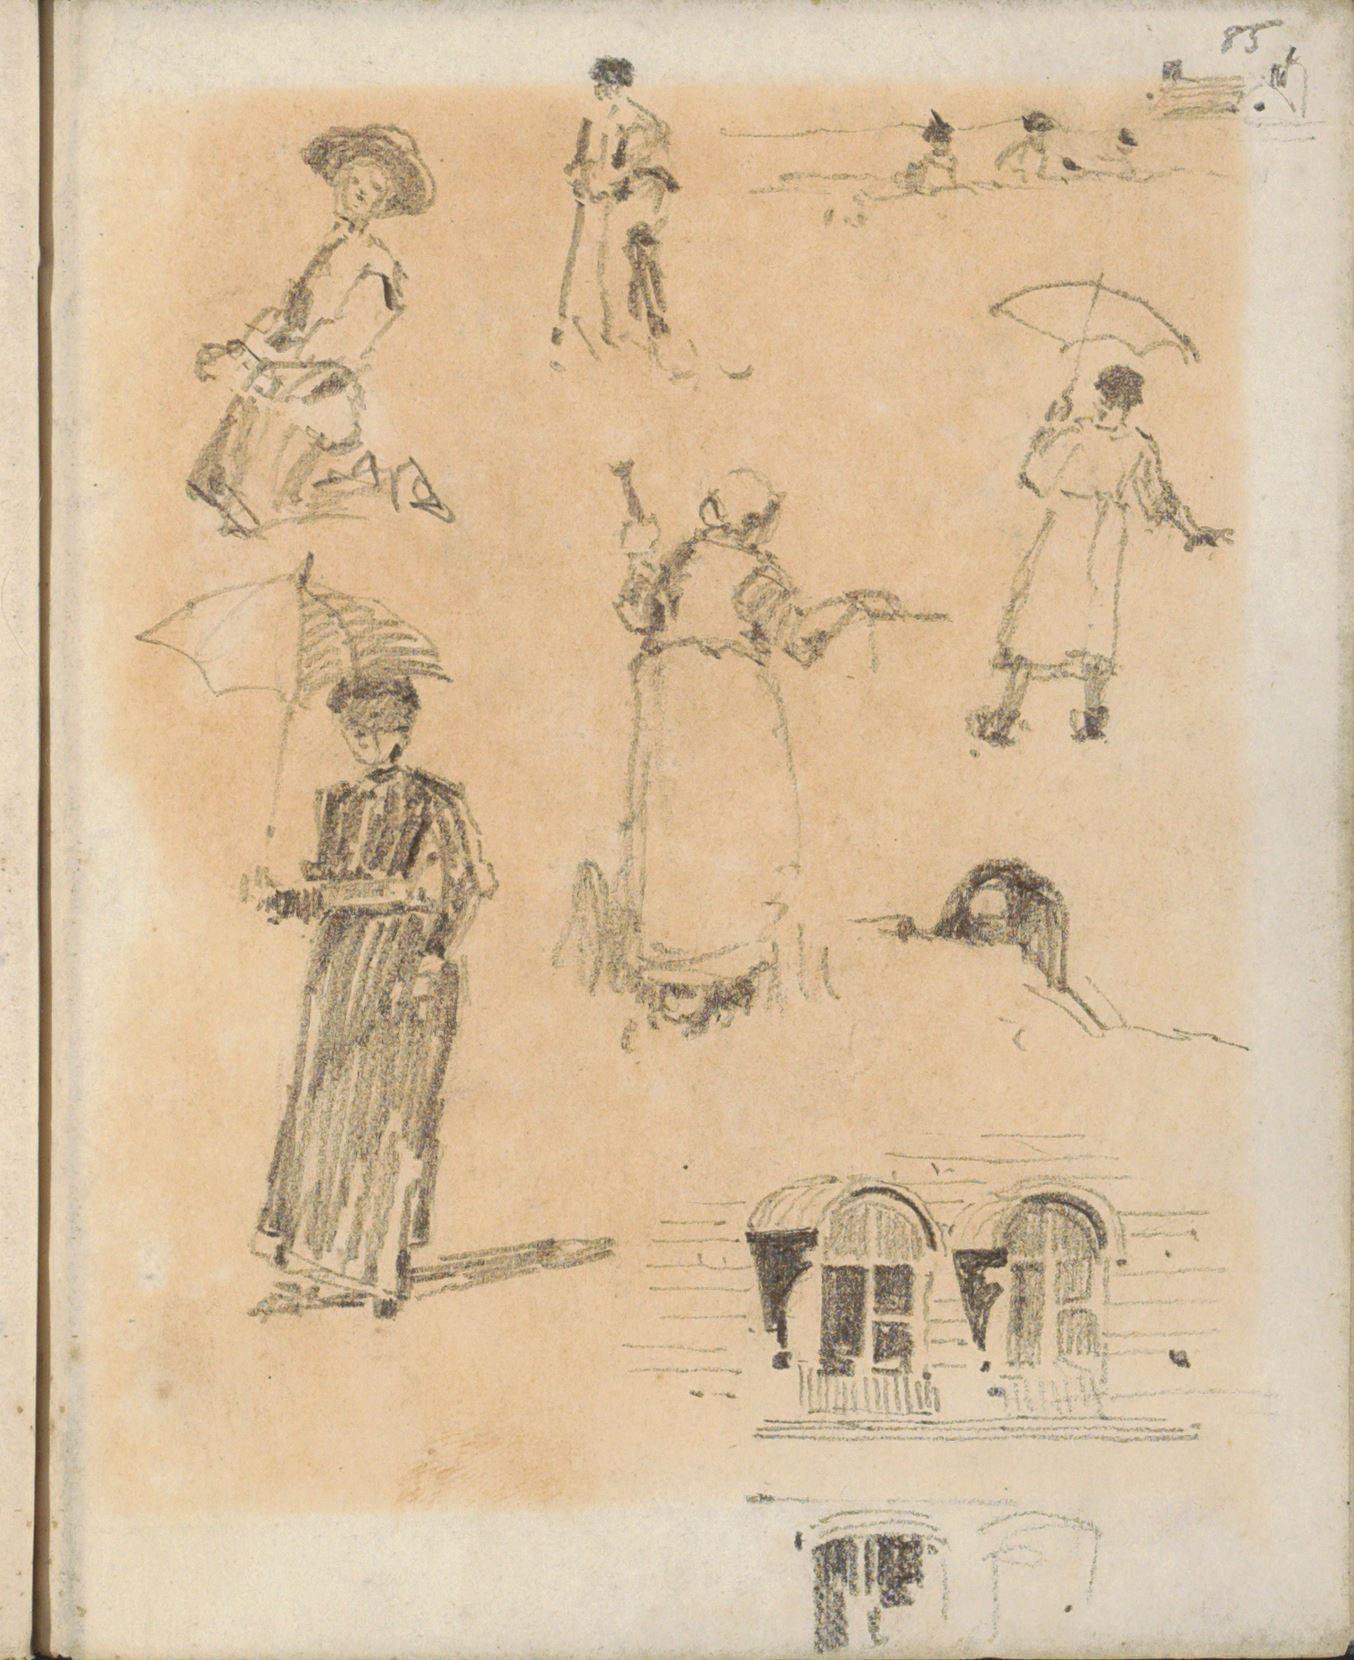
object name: sketchbook leaf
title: Studieblad, onder andere met vrouwen met parasols en architectuur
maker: alfred william rich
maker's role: draughtsman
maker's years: 1856-1921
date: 1892-1893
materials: paper, pencil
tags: architecture, parasol, sunshade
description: Tevens figuurstudies. Blad 85 recto uit een schetsboek met 86 bladen.